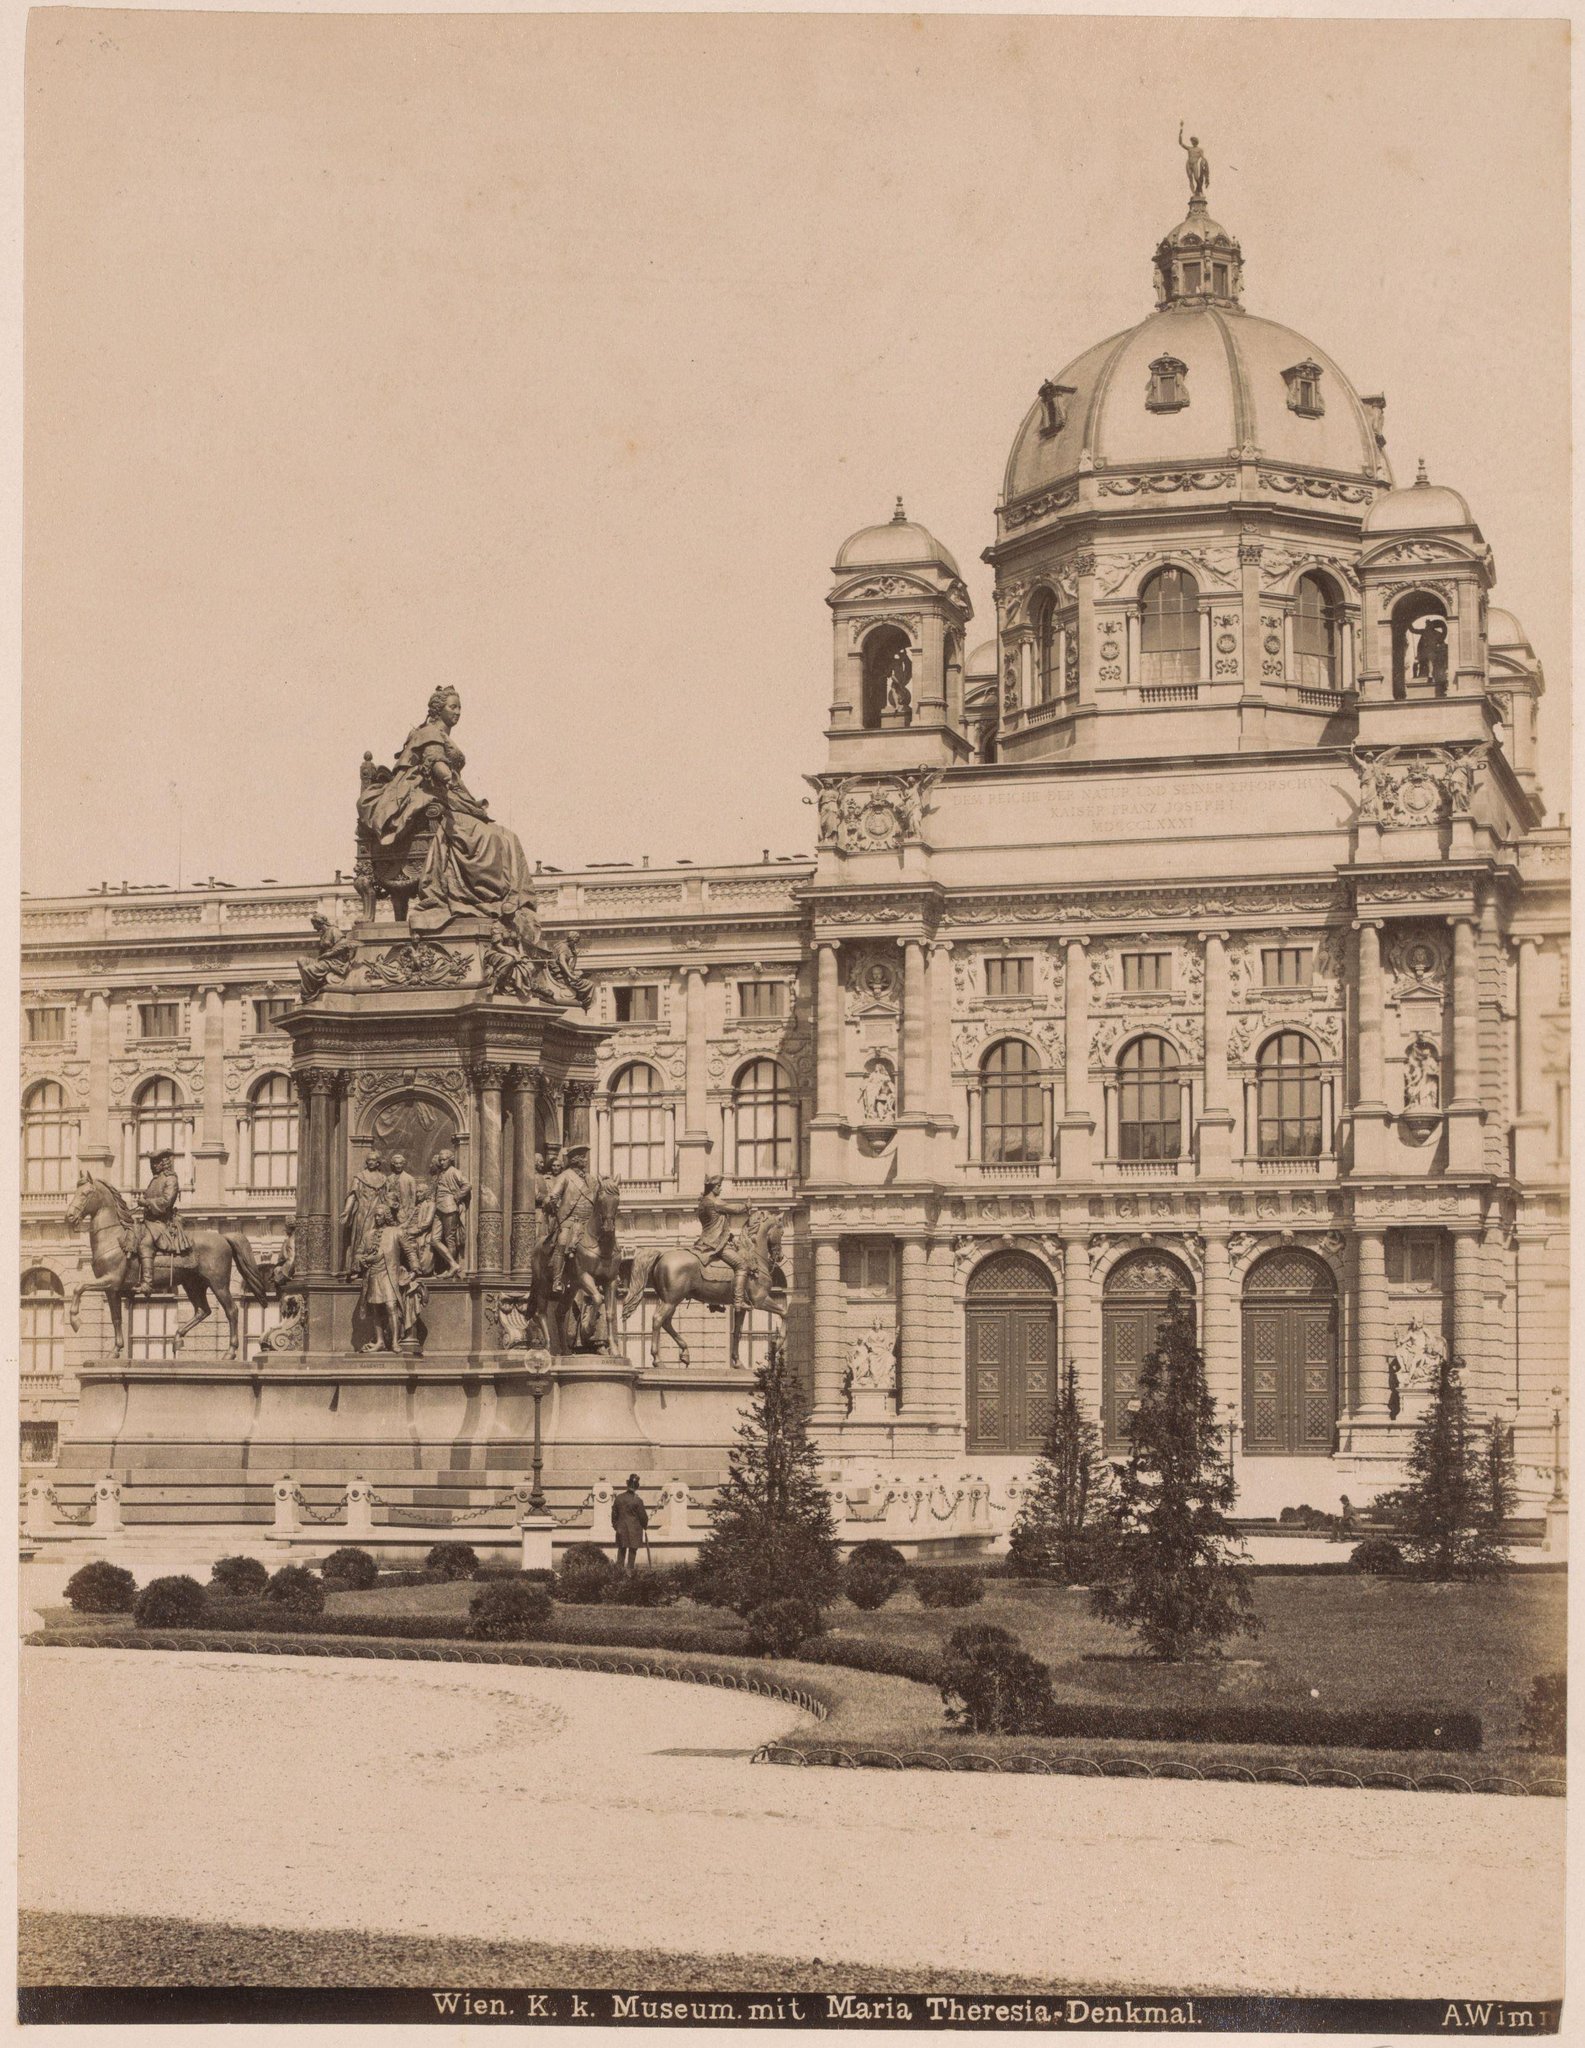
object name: photograph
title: Wien. K.k. Museum mit Maria Theresia-Denkmal.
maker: a. wimmer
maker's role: fotograaf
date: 1870-1900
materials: paper, photographic support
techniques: albumen print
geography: vienna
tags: monument, statue, permanent exhibition, museum, vienna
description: Onderdeel van Reisalbum met foto's van bezienswaardigheden in Duitsland en Oostenrijk en van kunstwerken.